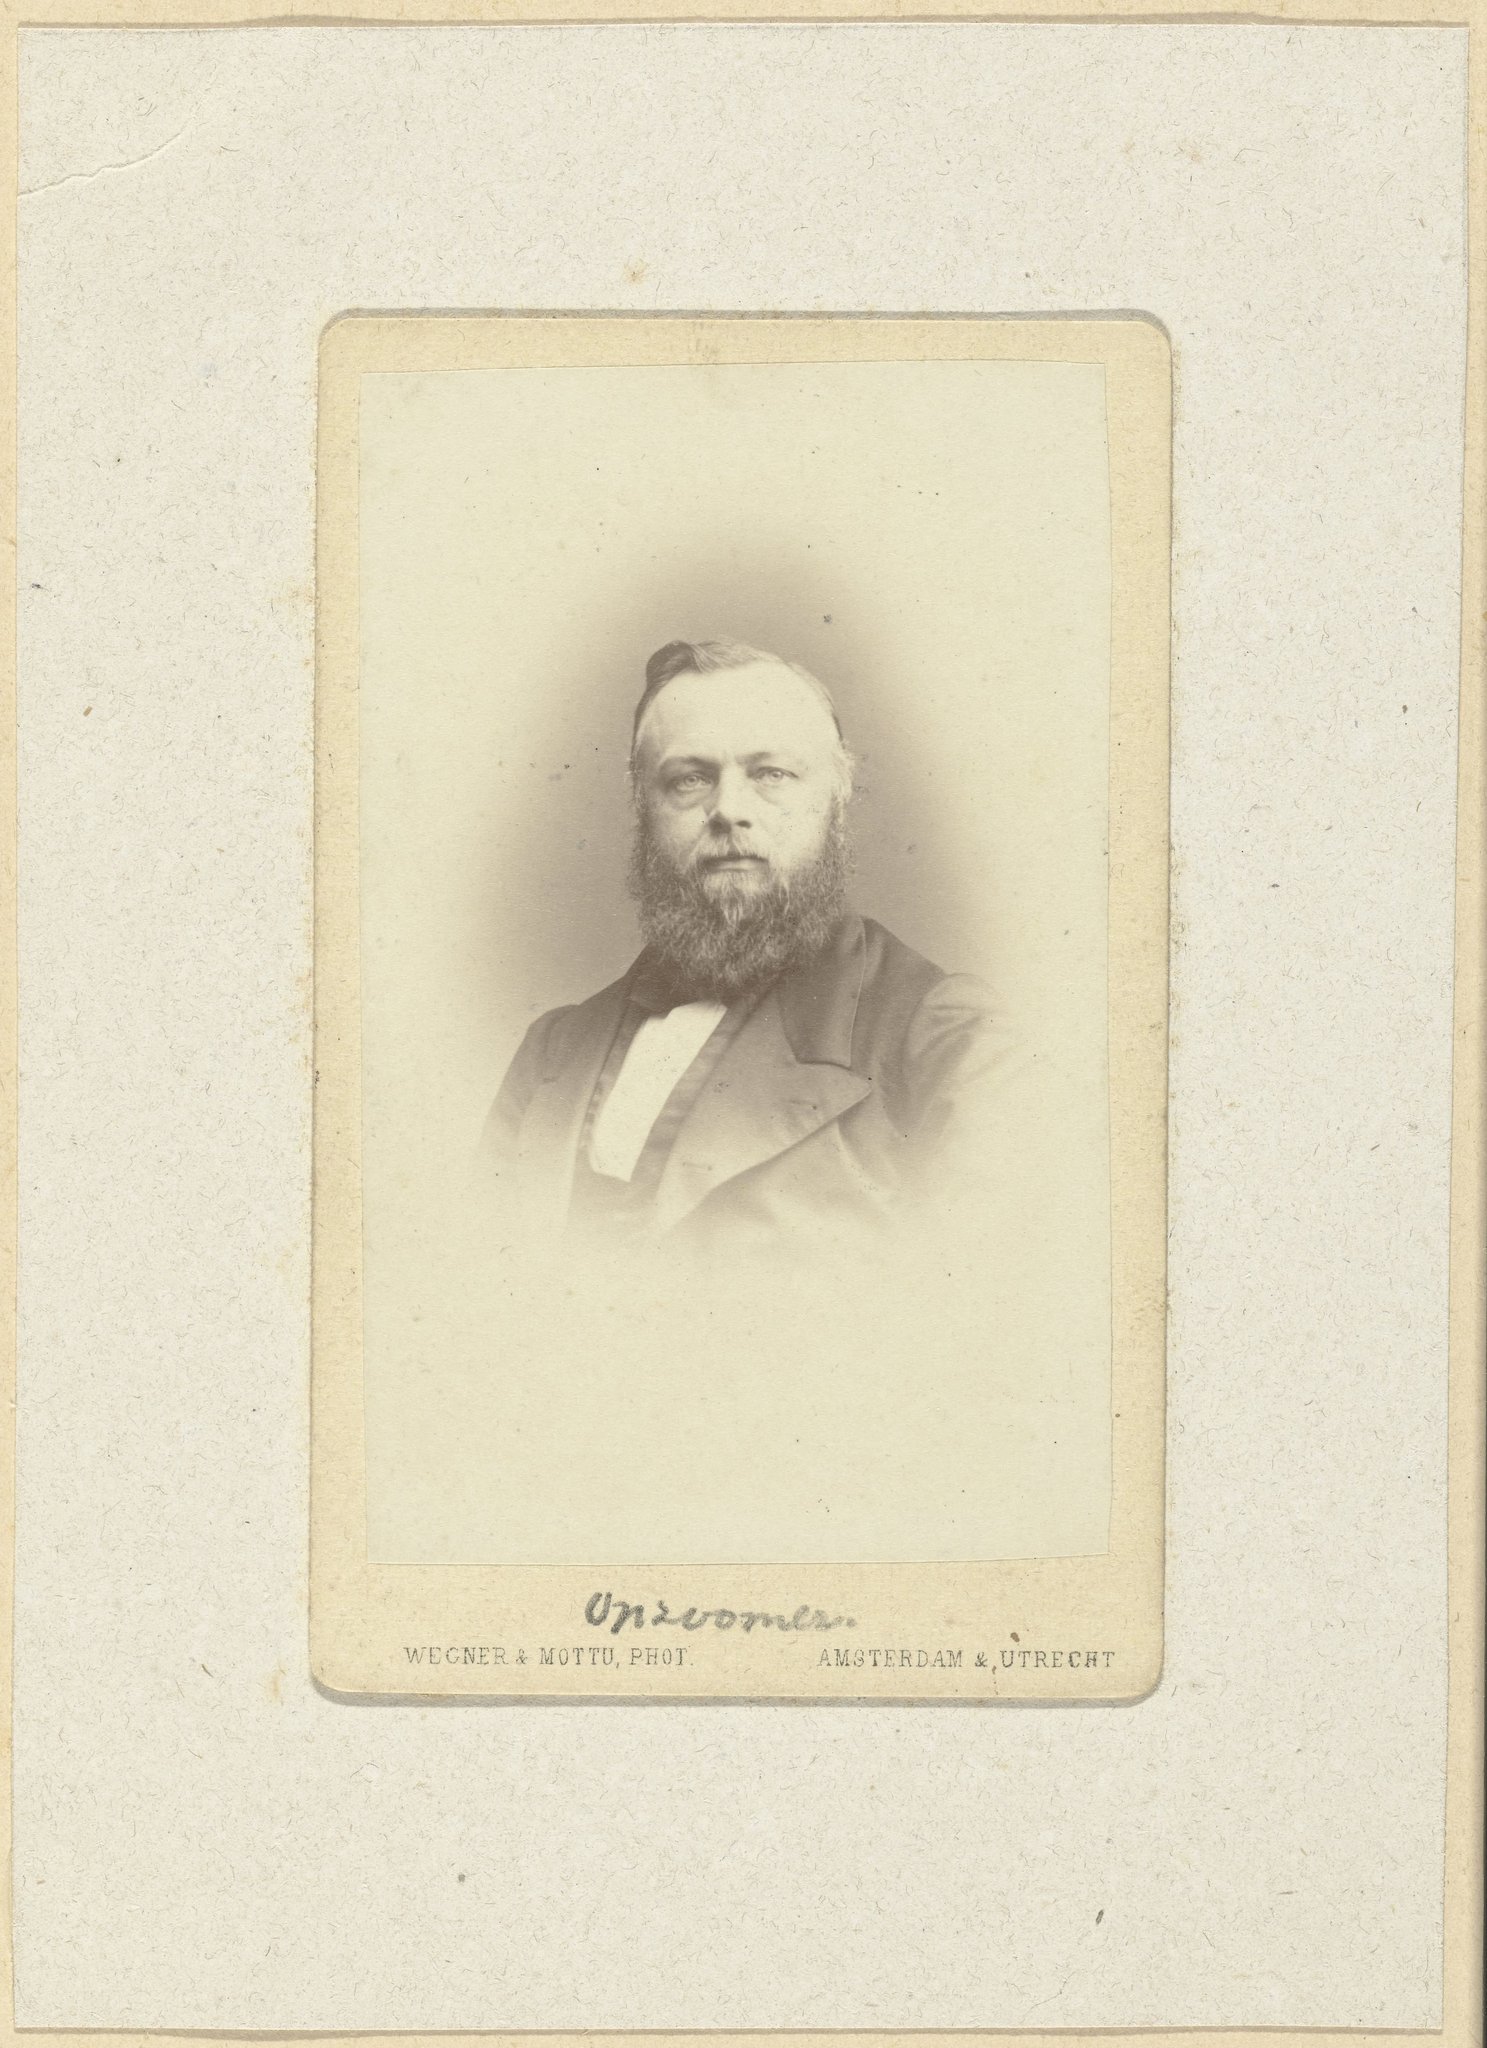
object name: photograph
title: Portret van C.W. Opzoomer, hoogleraar in de faculteit Wijsbegeerte en Letteren aan de universiteit van Utrecht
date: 1862-1875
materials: paper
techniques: albumen print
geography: amsterdam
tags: rotterdam, historical persons (portraits and scenes from the life)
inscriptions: title: ‘Opzoomer’